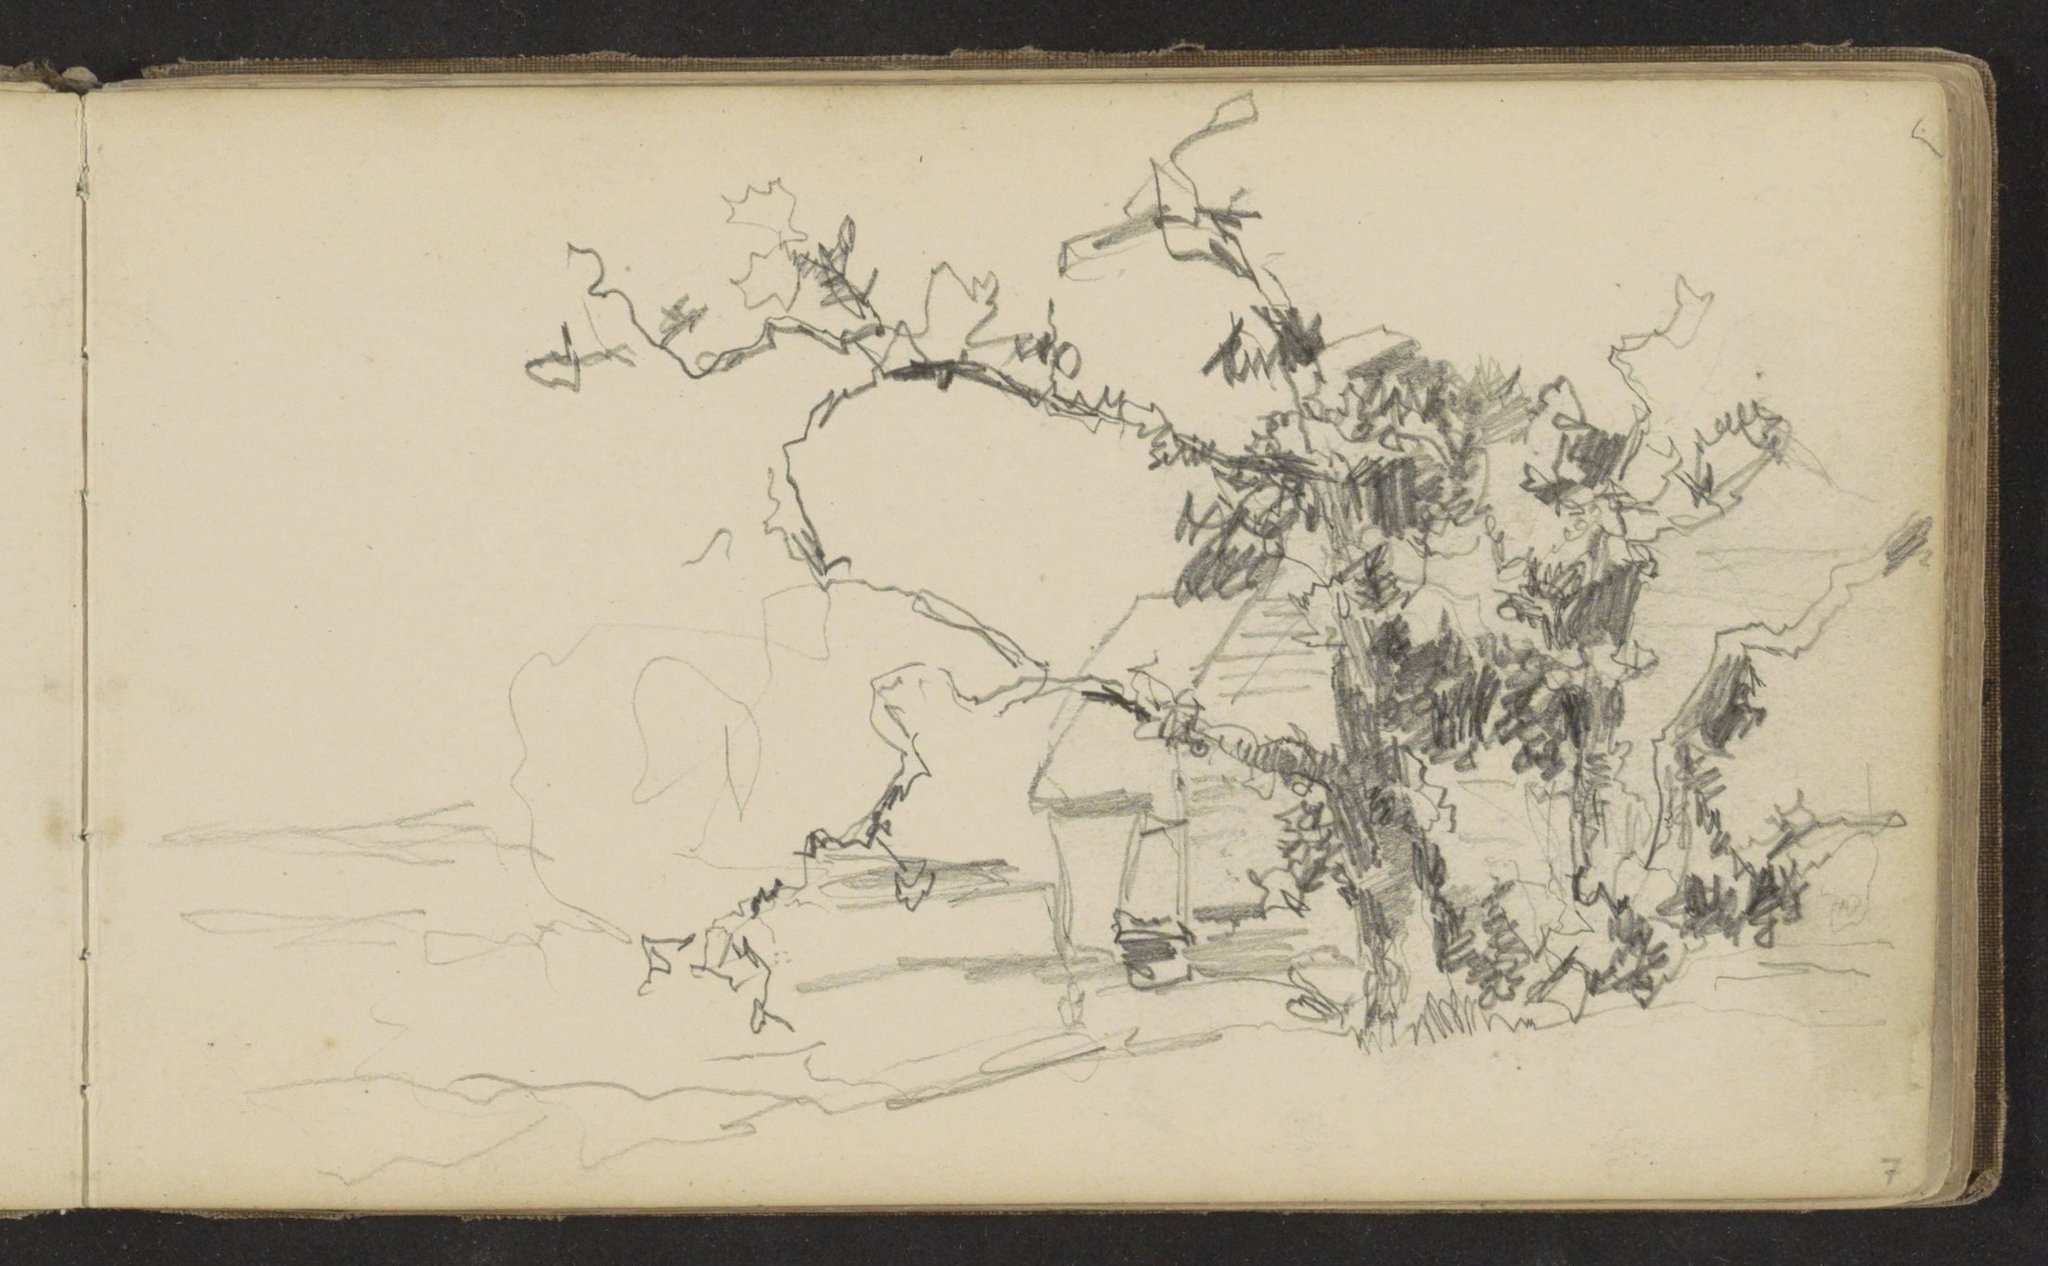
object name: sketchbook leaf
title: Bomengroep naast een boerenwoning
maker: johan hendrik weissenbruch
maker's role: draughtsman, painter, print maker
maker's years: 1824-1903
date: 1834-1903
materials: paper, pencil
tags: trees, cottage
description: Blad 7 recto uit een schetsboek met 43 bladen.